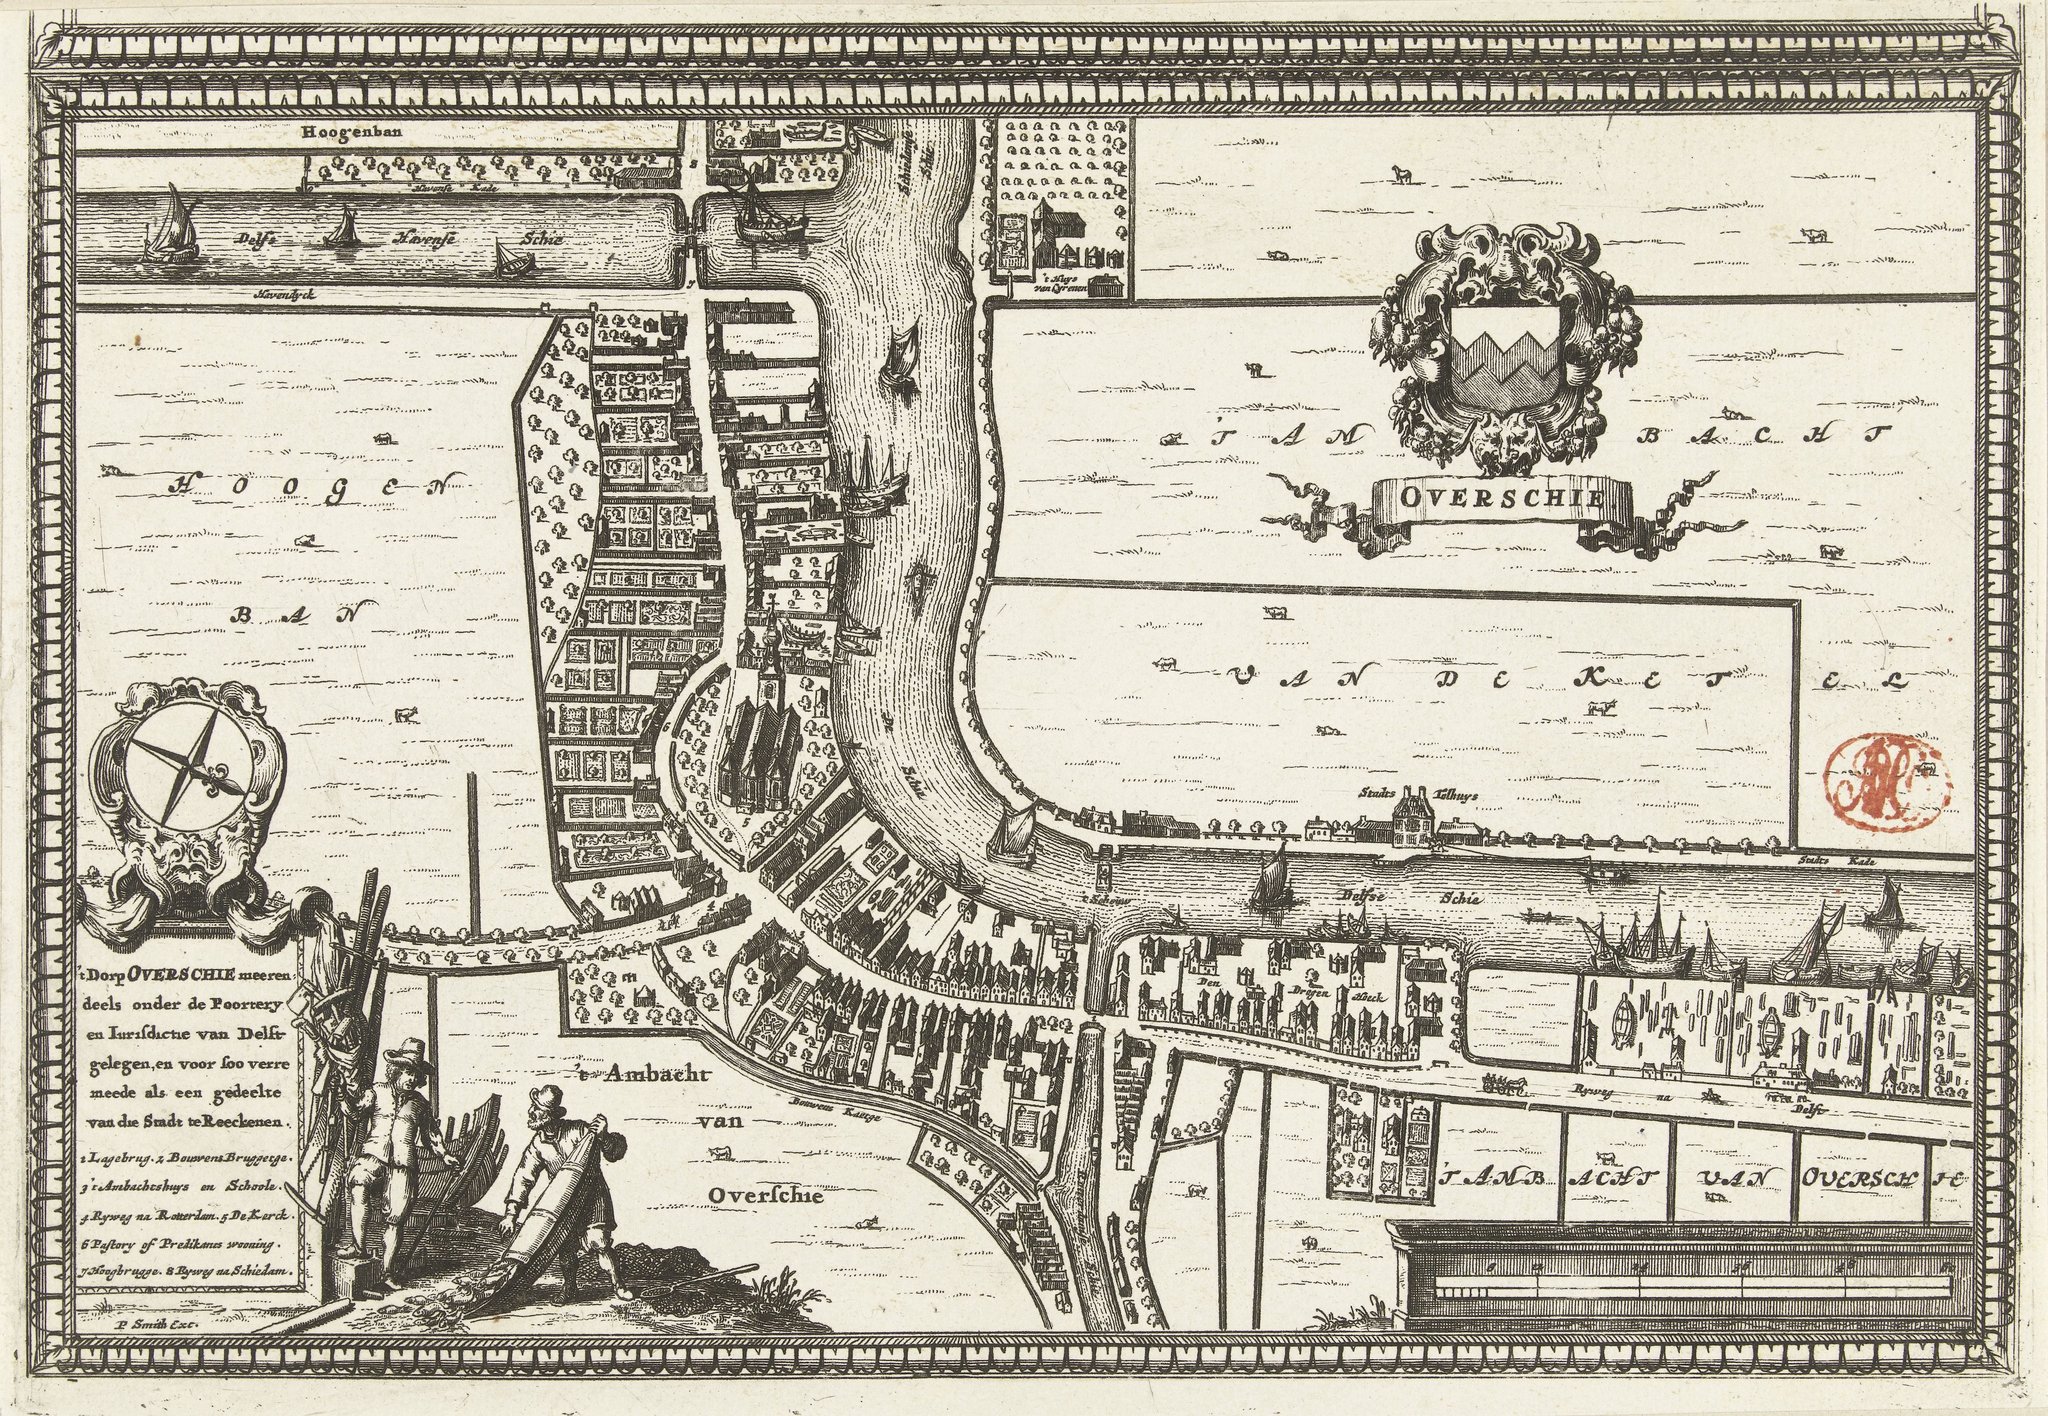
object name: area plan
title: Plattegrond van Overschie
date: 1678-1703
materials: paper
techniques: engraving, etching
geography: amsterdam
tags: coat of arms (as symbol of the state, etc.) (+ city; municipal), fisherman showing catch, maps of cities, fisherman, overschie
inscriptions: collector's mark: Lugt 195, collector's mark: Lugt 2228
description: Deze prent is in 1678 voor het eerst uitgegeven als onderdeel van de rand van de zogenaamde Kaart Figuratief (Caerte figuratyff / Kaerte figuratyf) van Delft, een wandkaart van Delft. Deze kaart bestaat uit een plattegrond van Delft (RP-P-AO-11-8A) met daaromheen een rand. De rand bestaat uit een profiel van Delft (RP-P-AO-11-11), een profiel van Delfshaven met daaronder de wapenschilden van de burgemeesters van de stad (RP-P-AO-13-51-1 en RP-P-AO-13-51-2), 24 kleinere prenten (kaarten, afbeeldingen van gebouwen en graven van bekende personen, o.a. huidige prent, RP-P-AO-11-15, RP-P-AO-11-16, RP-P-AO-11-17, RP-P-AO-11-18, RP-P-AO-11-19, RP-P-AO-11-20, RP-P-AO-11-21, RP-P-AO-11-23, RP-P-AO-11-24, RP-P-AO-11-27, RP-P-AO-11-28, RP-P-AO-11-29, RP-P-AO-11-30, RP-P-AO-11-31, RP-P-AO-11-33C, RP-P-AO-11-34, RP-P-AO-11-35-2, RP-P-AO-13-49, RP-P-AO-13-52, RP-P-AO-13-53, RP-P-AO-13-54-1 en RP-P-1909-6463) en een beschrijving van de stad (RP-P-AO-11-8E). De eerste druk van deze Kaart Figuratief (1678) werd, in opdracht van het Delftse stadsbestuur, verzorgd door Pieter Smith. In 1680 leverde Smith ook vijfhonderd afdrukken van de randprenten die bestemd waren voor Dirk Evertsz. Bleyswijcks 'Beschryvinge der stadt Delft' (1667) en het tweede deel: 'Vervolg van de beschryvinge der stadt Delft' (1680). In het tweede deel zat een bijlage waarin beschreven staat welke prenten waar in het eerste en tweede deel ingebonden dienden te worden. Een deel van de prenten was dus bestemd voor het in 1667 verschenen eerste deel en kon met het verschijnen van het tweede deel in 1680 alsnog worden ingebonden. Hierdoor wordt vaak gedacht dat de prenten uit het eerste deel dateren uit 1667, hetgeen niet klopt. De huidige prent is zodoende ook gebruikt in: Bleyswijck, Dirk Evertsz. Beschryvinge der stadt Delft, betreffende des selfs situatie, oorsprong en ouderdom, opkomst en voortgangh (…). Delft: Arnold Bon, 1667 (prenten vanaf 1680 ingebonden), p. 30. Pieter Mortier (I) verzorgde in 1703, tevens in opdracht van het stadsbestuur, een tweede uitgave van de Kaart Figuratief. Voor deze druk bracht graveur Thomas van der Wilt enkele aanpassingen aan op de platen van de plattegrond. De randplaten lijken, op de plaat met de wapens van de burgemeesters na, ongewijzigd te zijn gebleven. De plattegrond is in 1752, waarschijnlijk zonder de randprenten, opnieuw uitgegeven. Of de huidige prent is gebruikt als onderdeel van de rand van de Kaart Figuratief uit 1678 of 1703, of is gebruikt in 'Beschryvinge der stadt Delft' (1667, prenten 1680), is niet na te gaan.